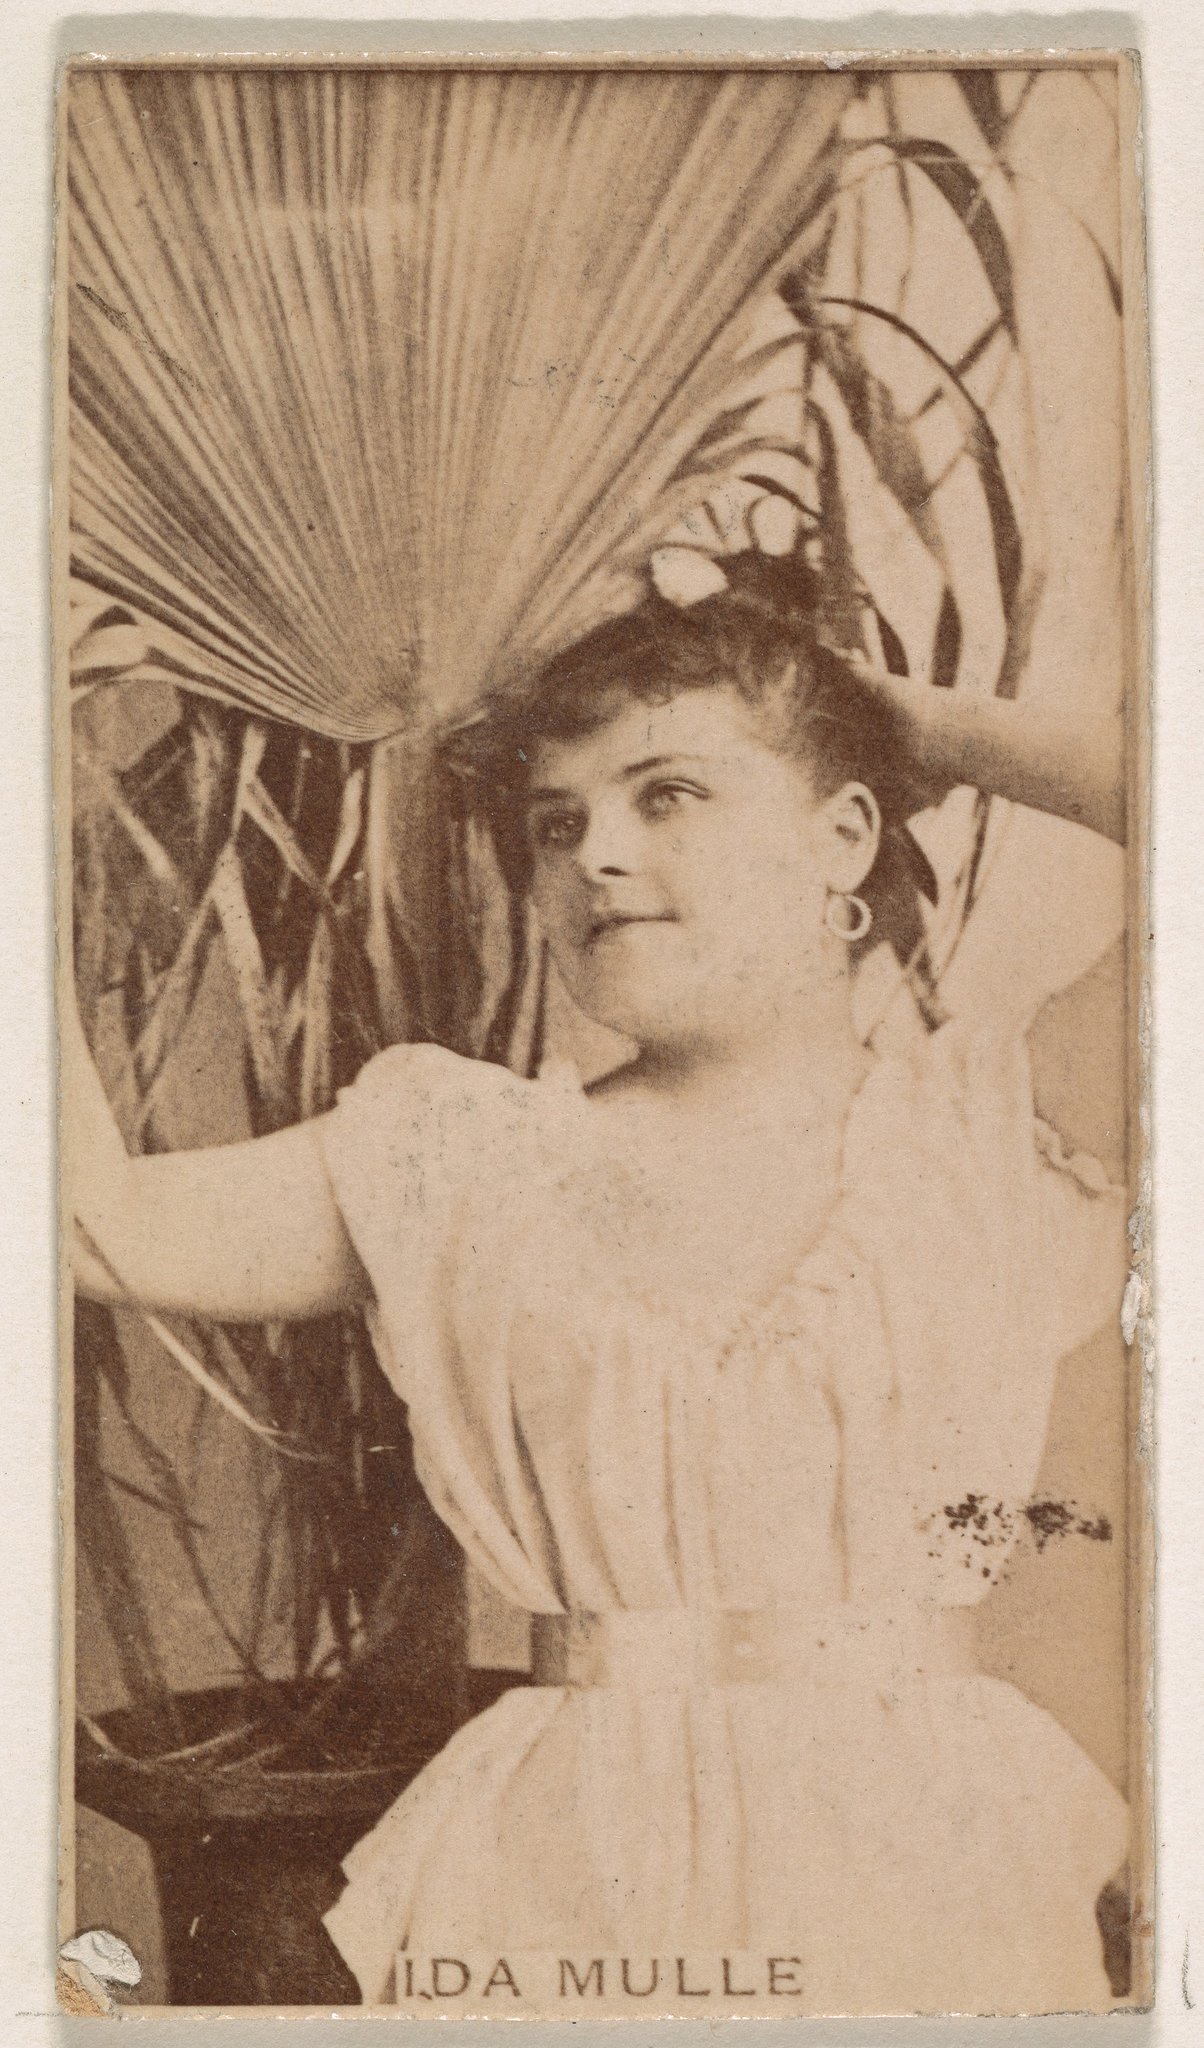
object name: photograph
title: Ida Mulle, from the Actresses series (N245) issued by Kinney Brothers to promote Sweet Caporal Cigarettes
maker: kinney brothers tobacco company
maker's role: publisher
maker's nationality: american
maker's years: 1869-2011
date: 1890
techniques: albumen silver print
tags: portraits,women,actresses